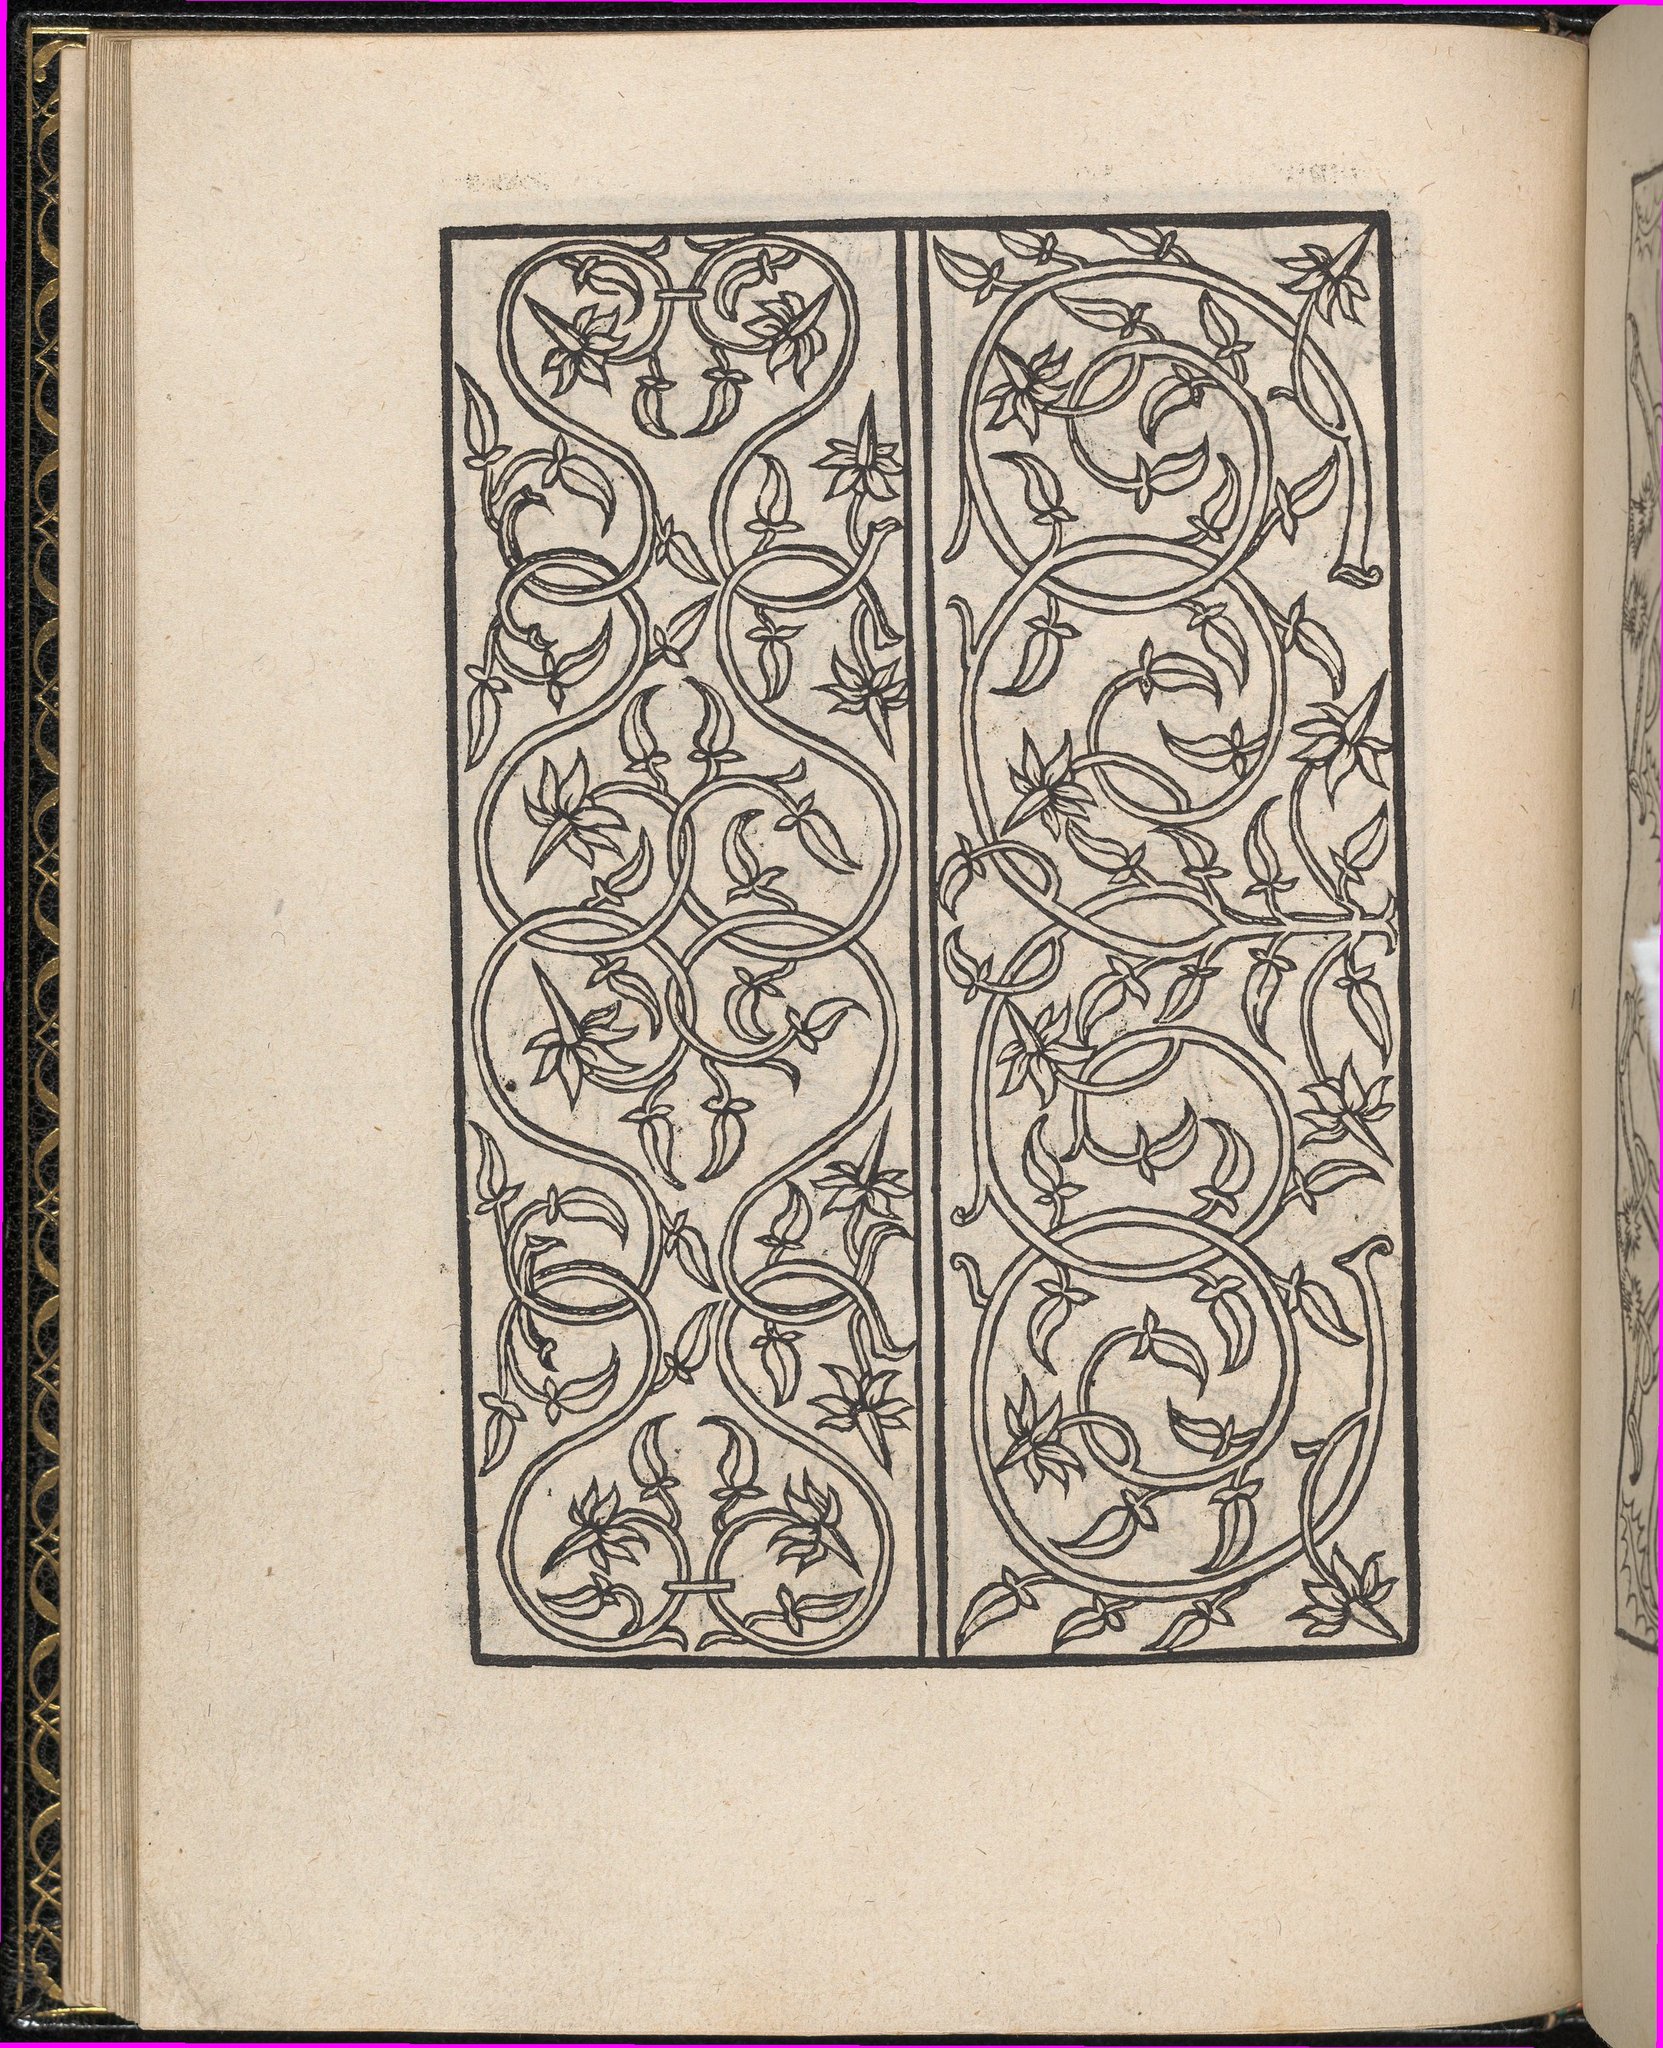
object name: book print ornament architecture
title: Page from Ein new kunstlich Modelbuch...(Page 16v)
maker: peter quentel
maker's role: publisher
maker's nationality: german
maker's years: 1500-1550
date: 1544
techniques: woodcut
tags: ornament